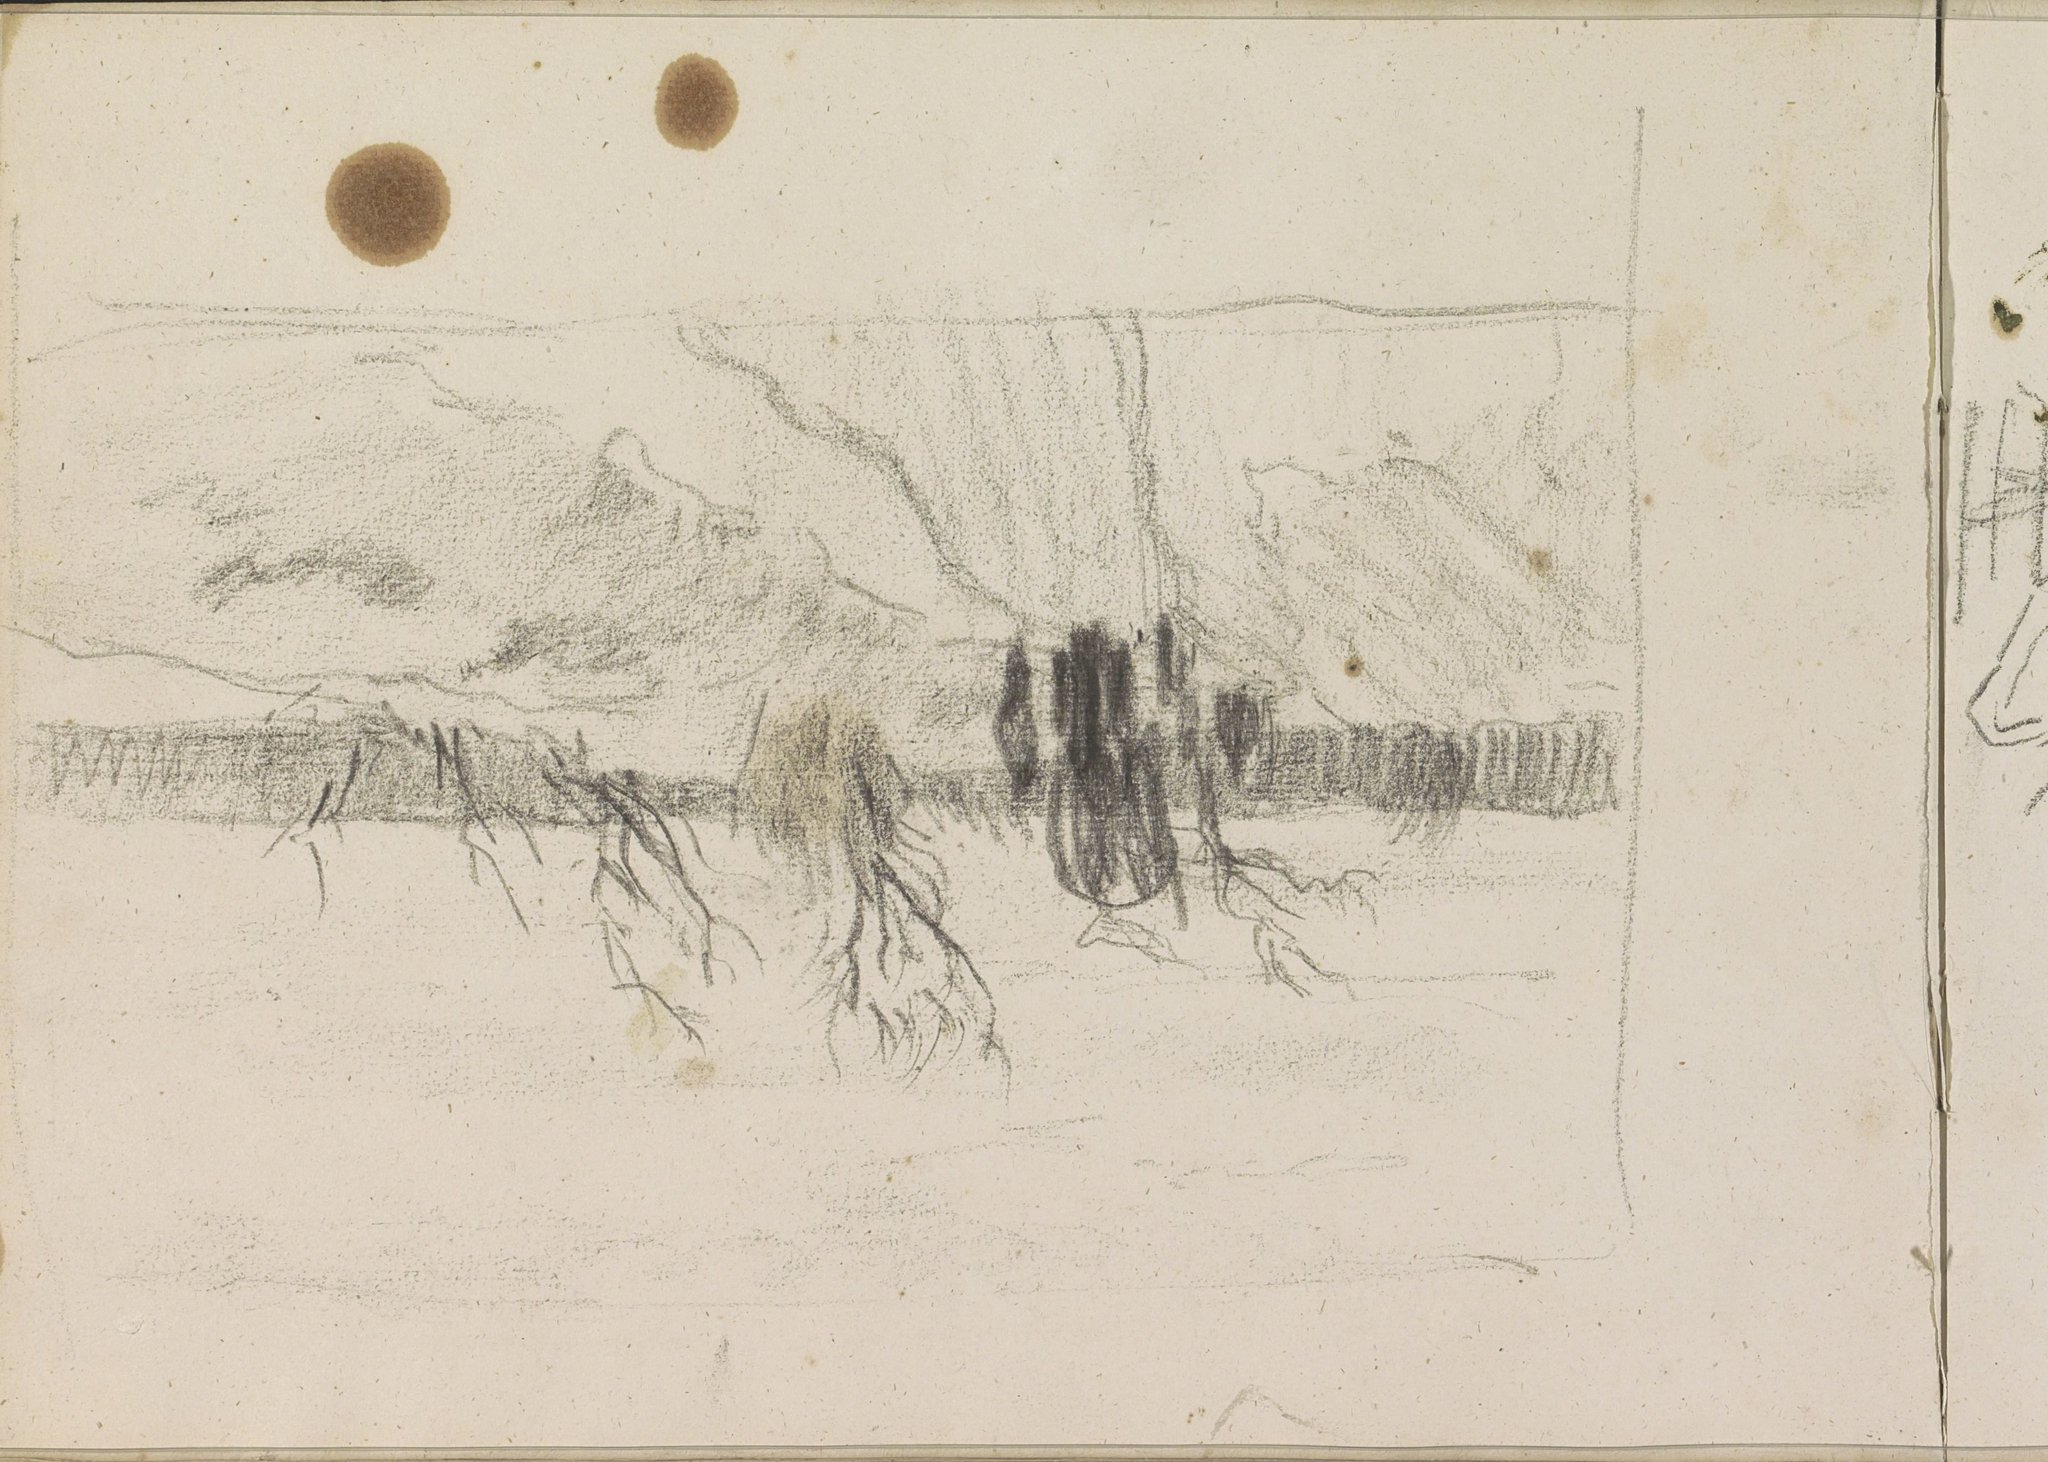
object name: sketchbook leaf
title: Pad in een landschap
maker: anton mauve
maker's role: draughtsman, painter, print maker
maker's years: 1838-1888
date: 1848-1888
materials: chalk, paper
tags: landscapes, road, path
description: Op het pad mogelijk figuren of een kar. Blad 20 verso uit een schetsboek met 34 bladen.